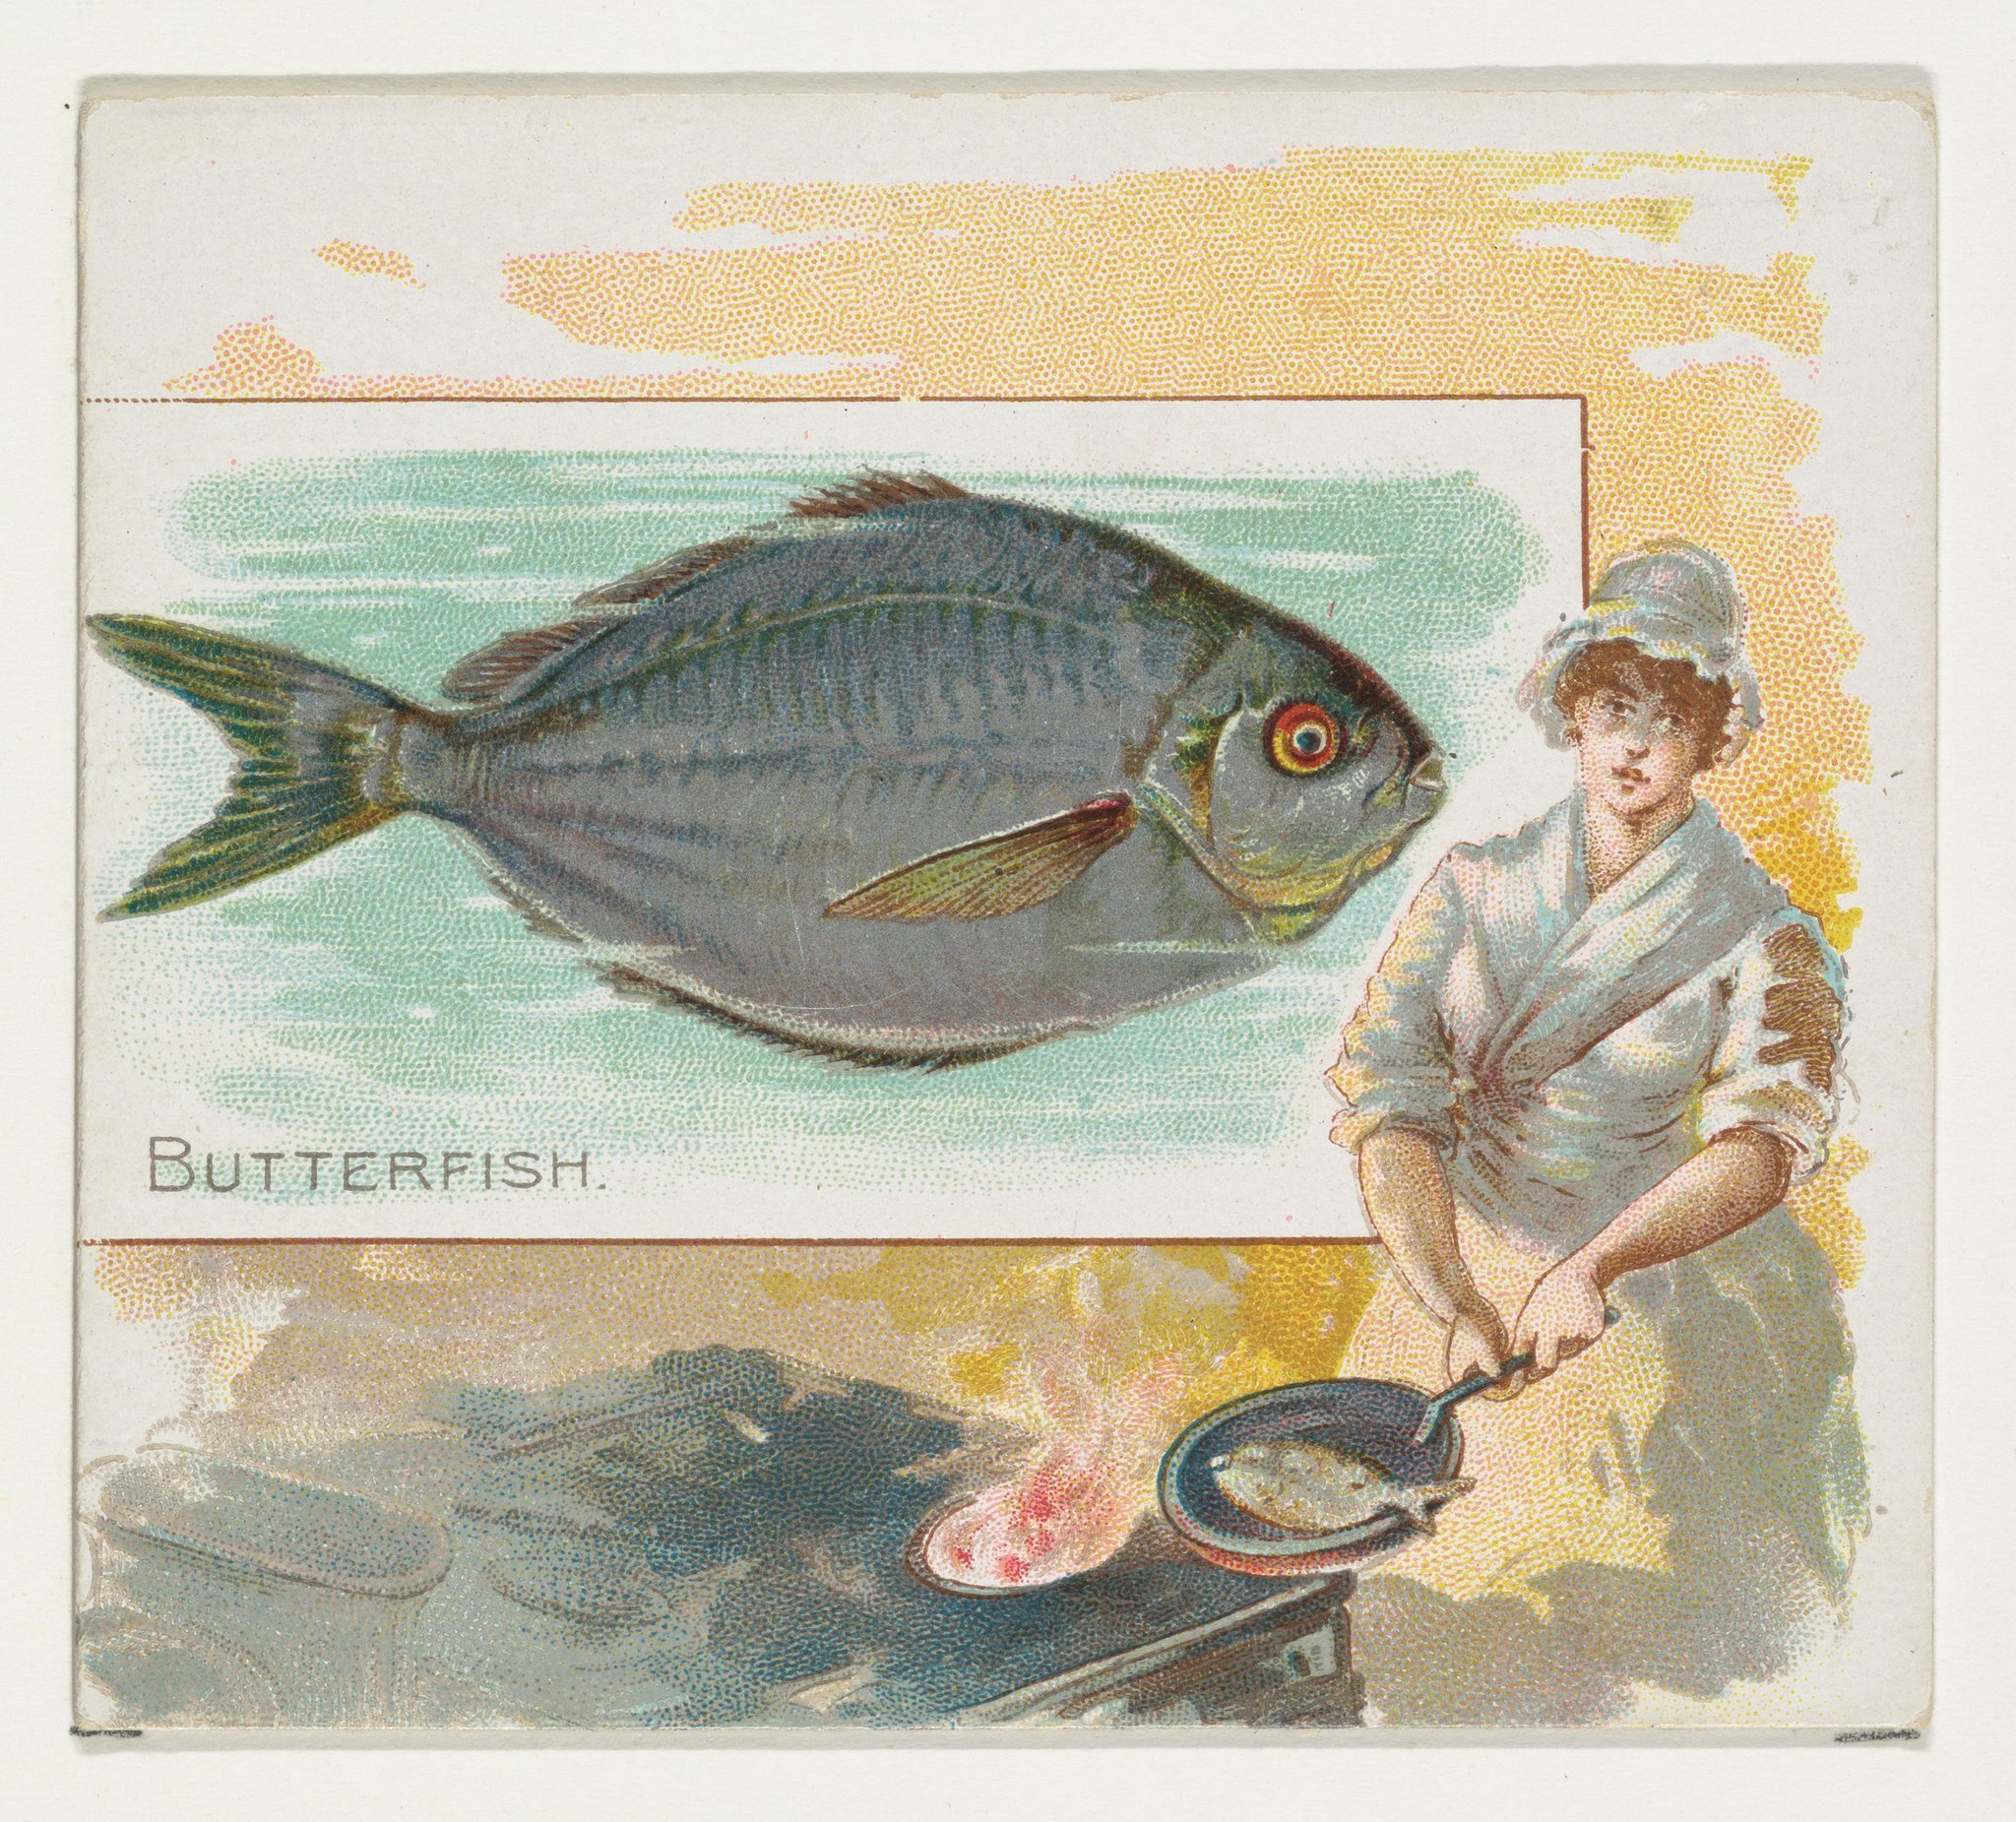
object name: print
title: Butterfish, from Fish from American Waters series (N39) for Allen & Ginter Cigarettes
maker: allen & ginter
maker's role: publisher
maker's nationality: american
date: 1889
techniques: color lithograph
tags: women,fish,cooking